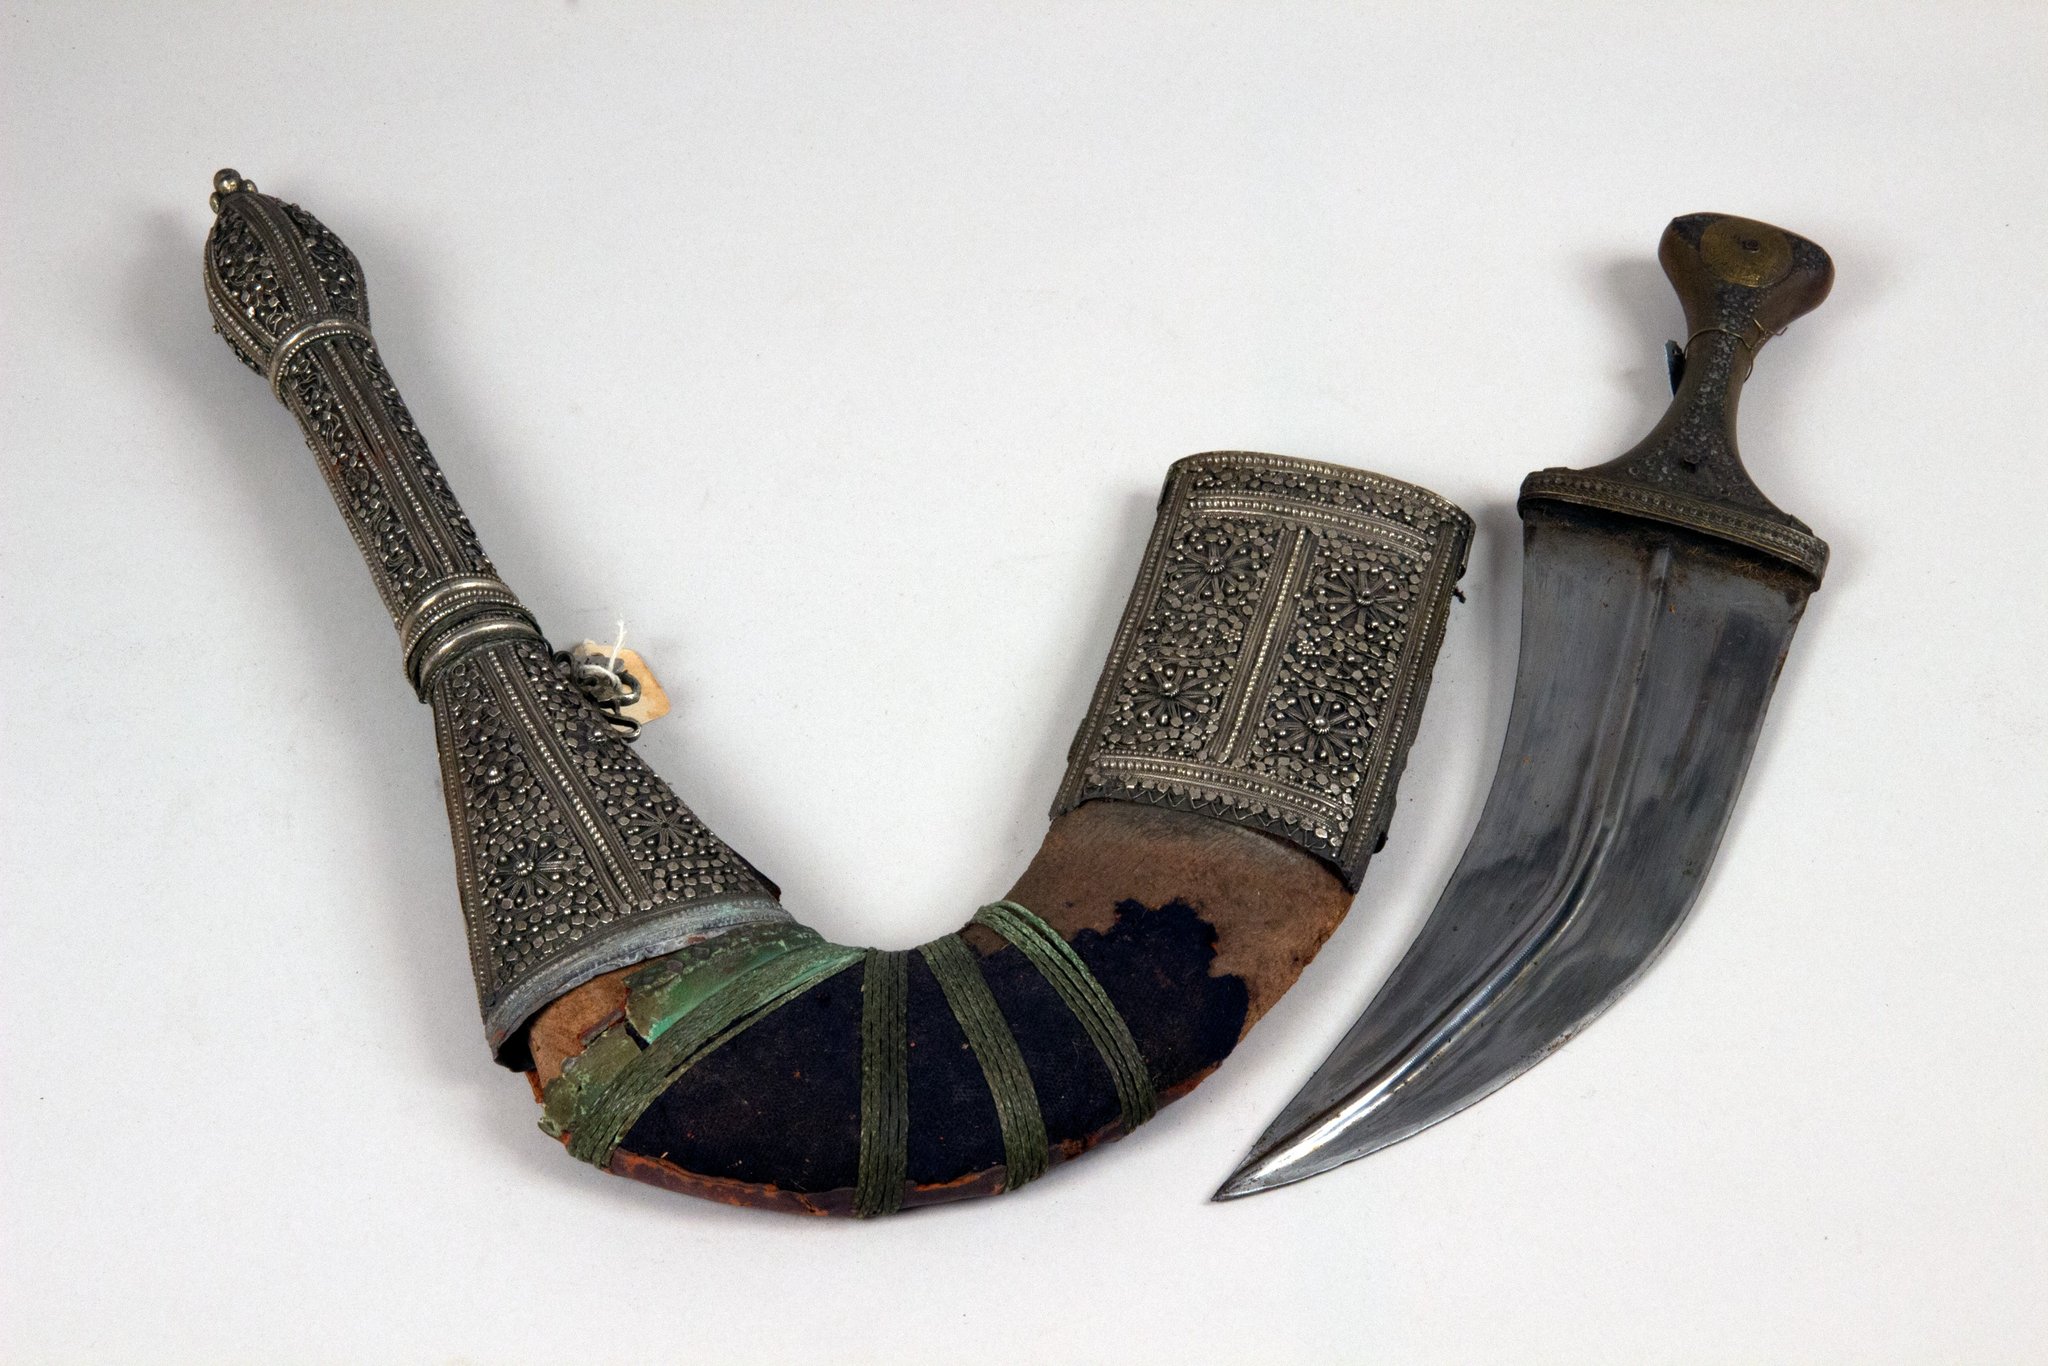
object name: dagger jambiya with sheath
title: Dagger (Jambiya) with Sheath and Belt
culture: arabian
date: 1801-1900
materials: brass, gold, leather, silver, steel, textile, wood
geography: saudi arabia